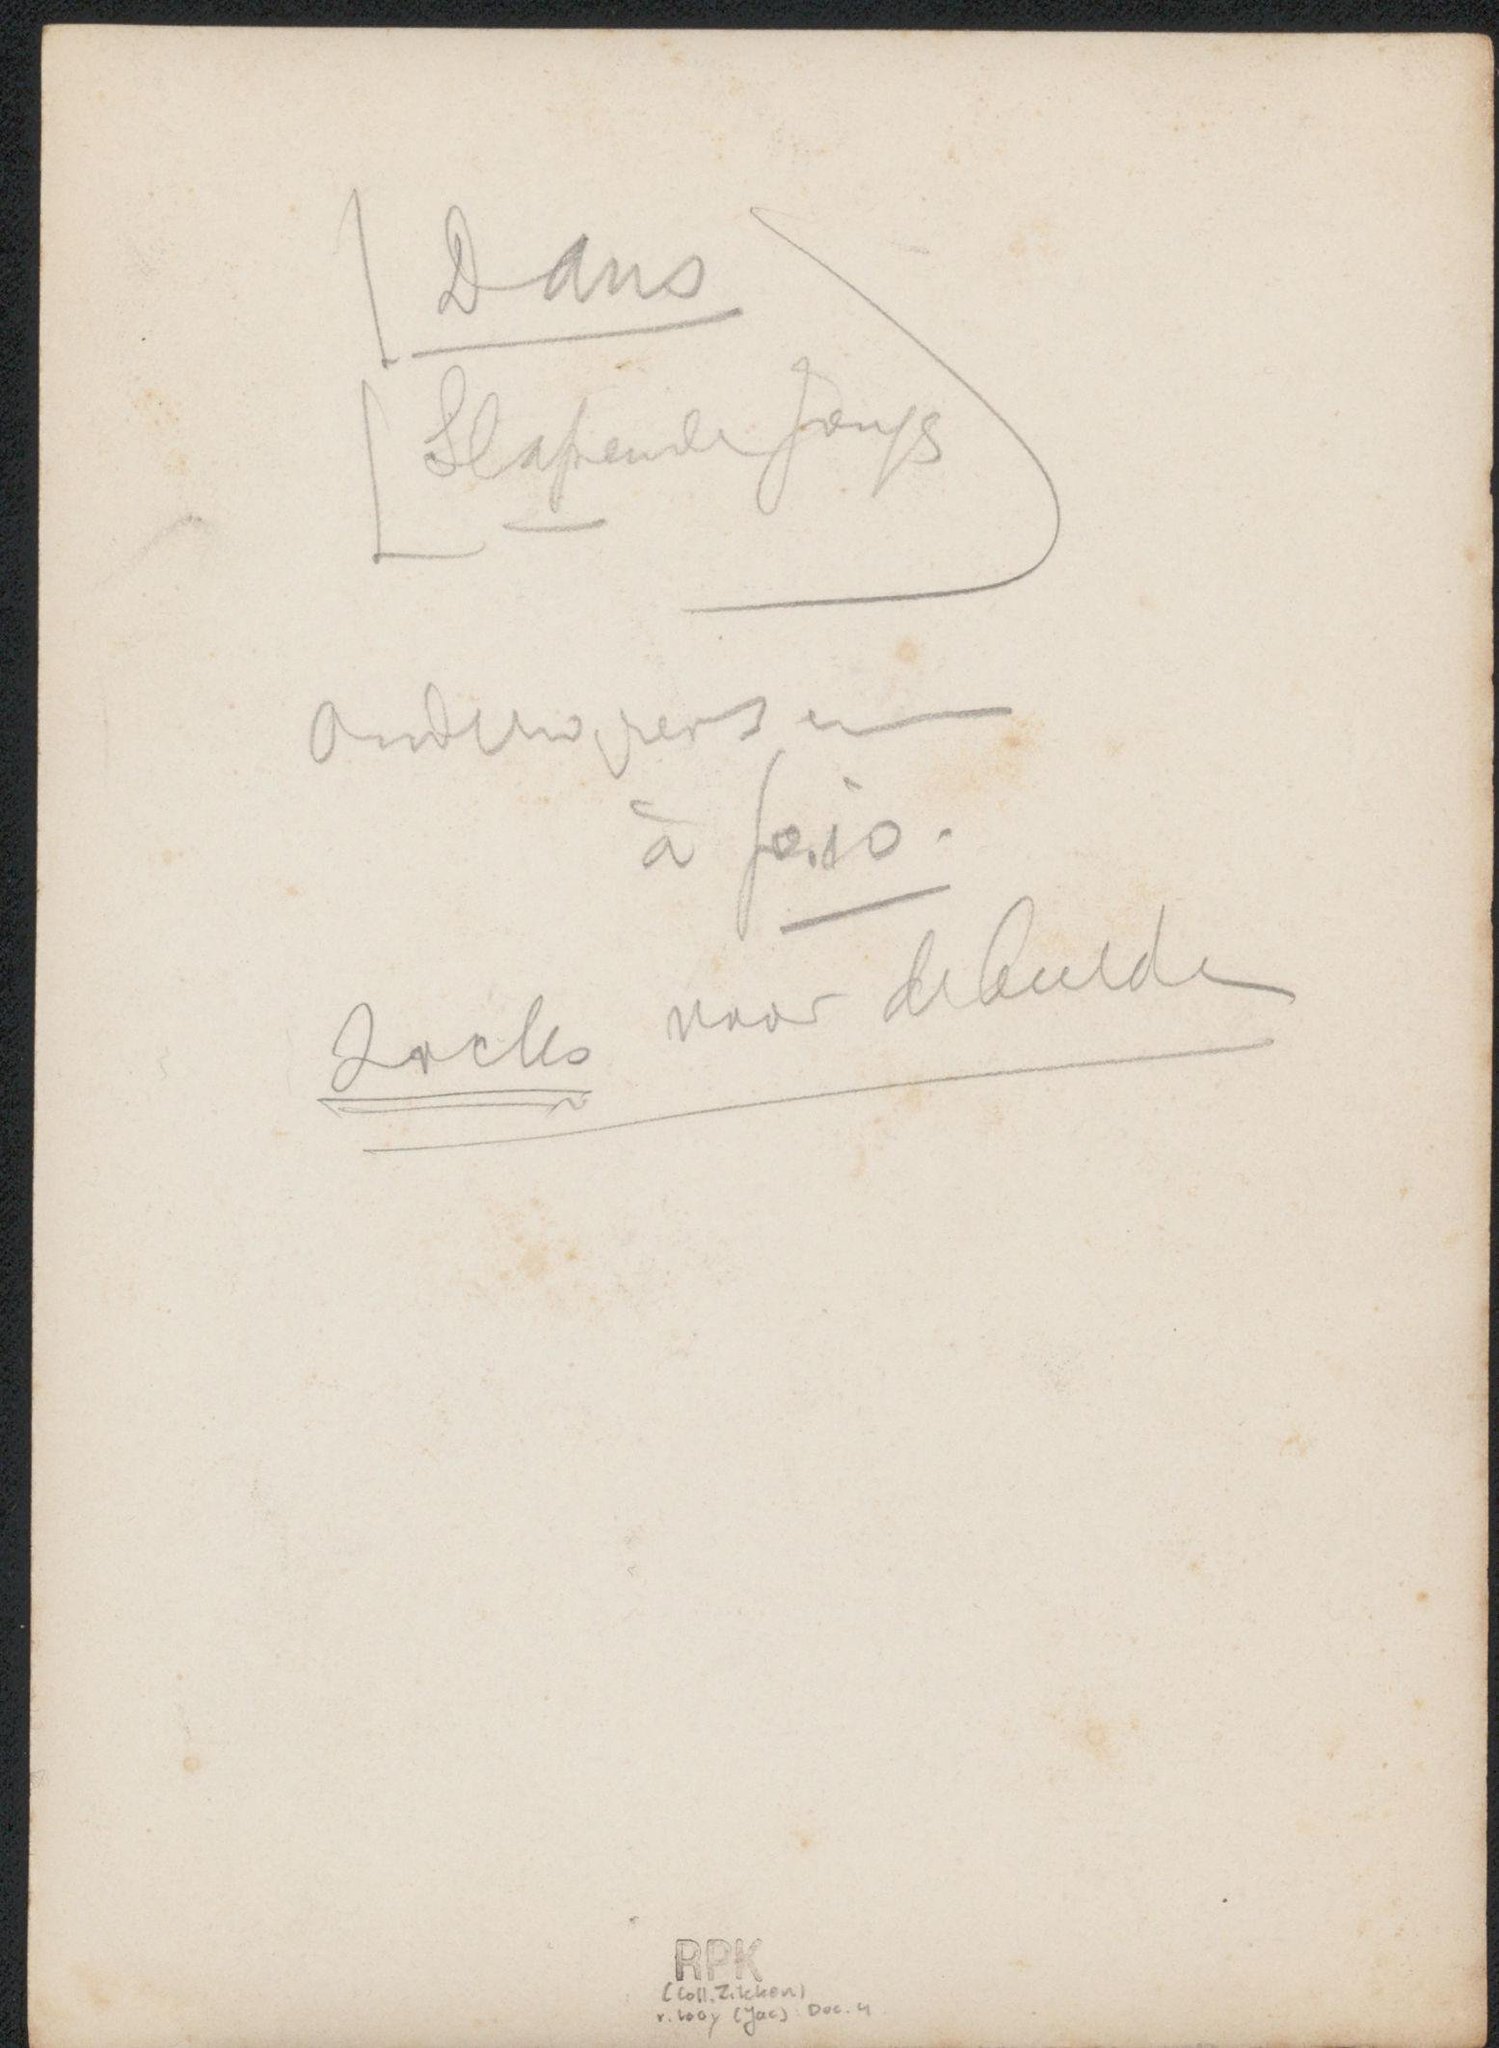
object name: photograph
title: Foto uit archief Philip Zilcken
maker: Anonymous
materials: photographic support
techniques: gelatin silver print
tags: the hague, painter, draughtsman, philip zilcken, reaping, picking, mowing ~ harvest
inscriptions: collector's mark: ‘RPK’